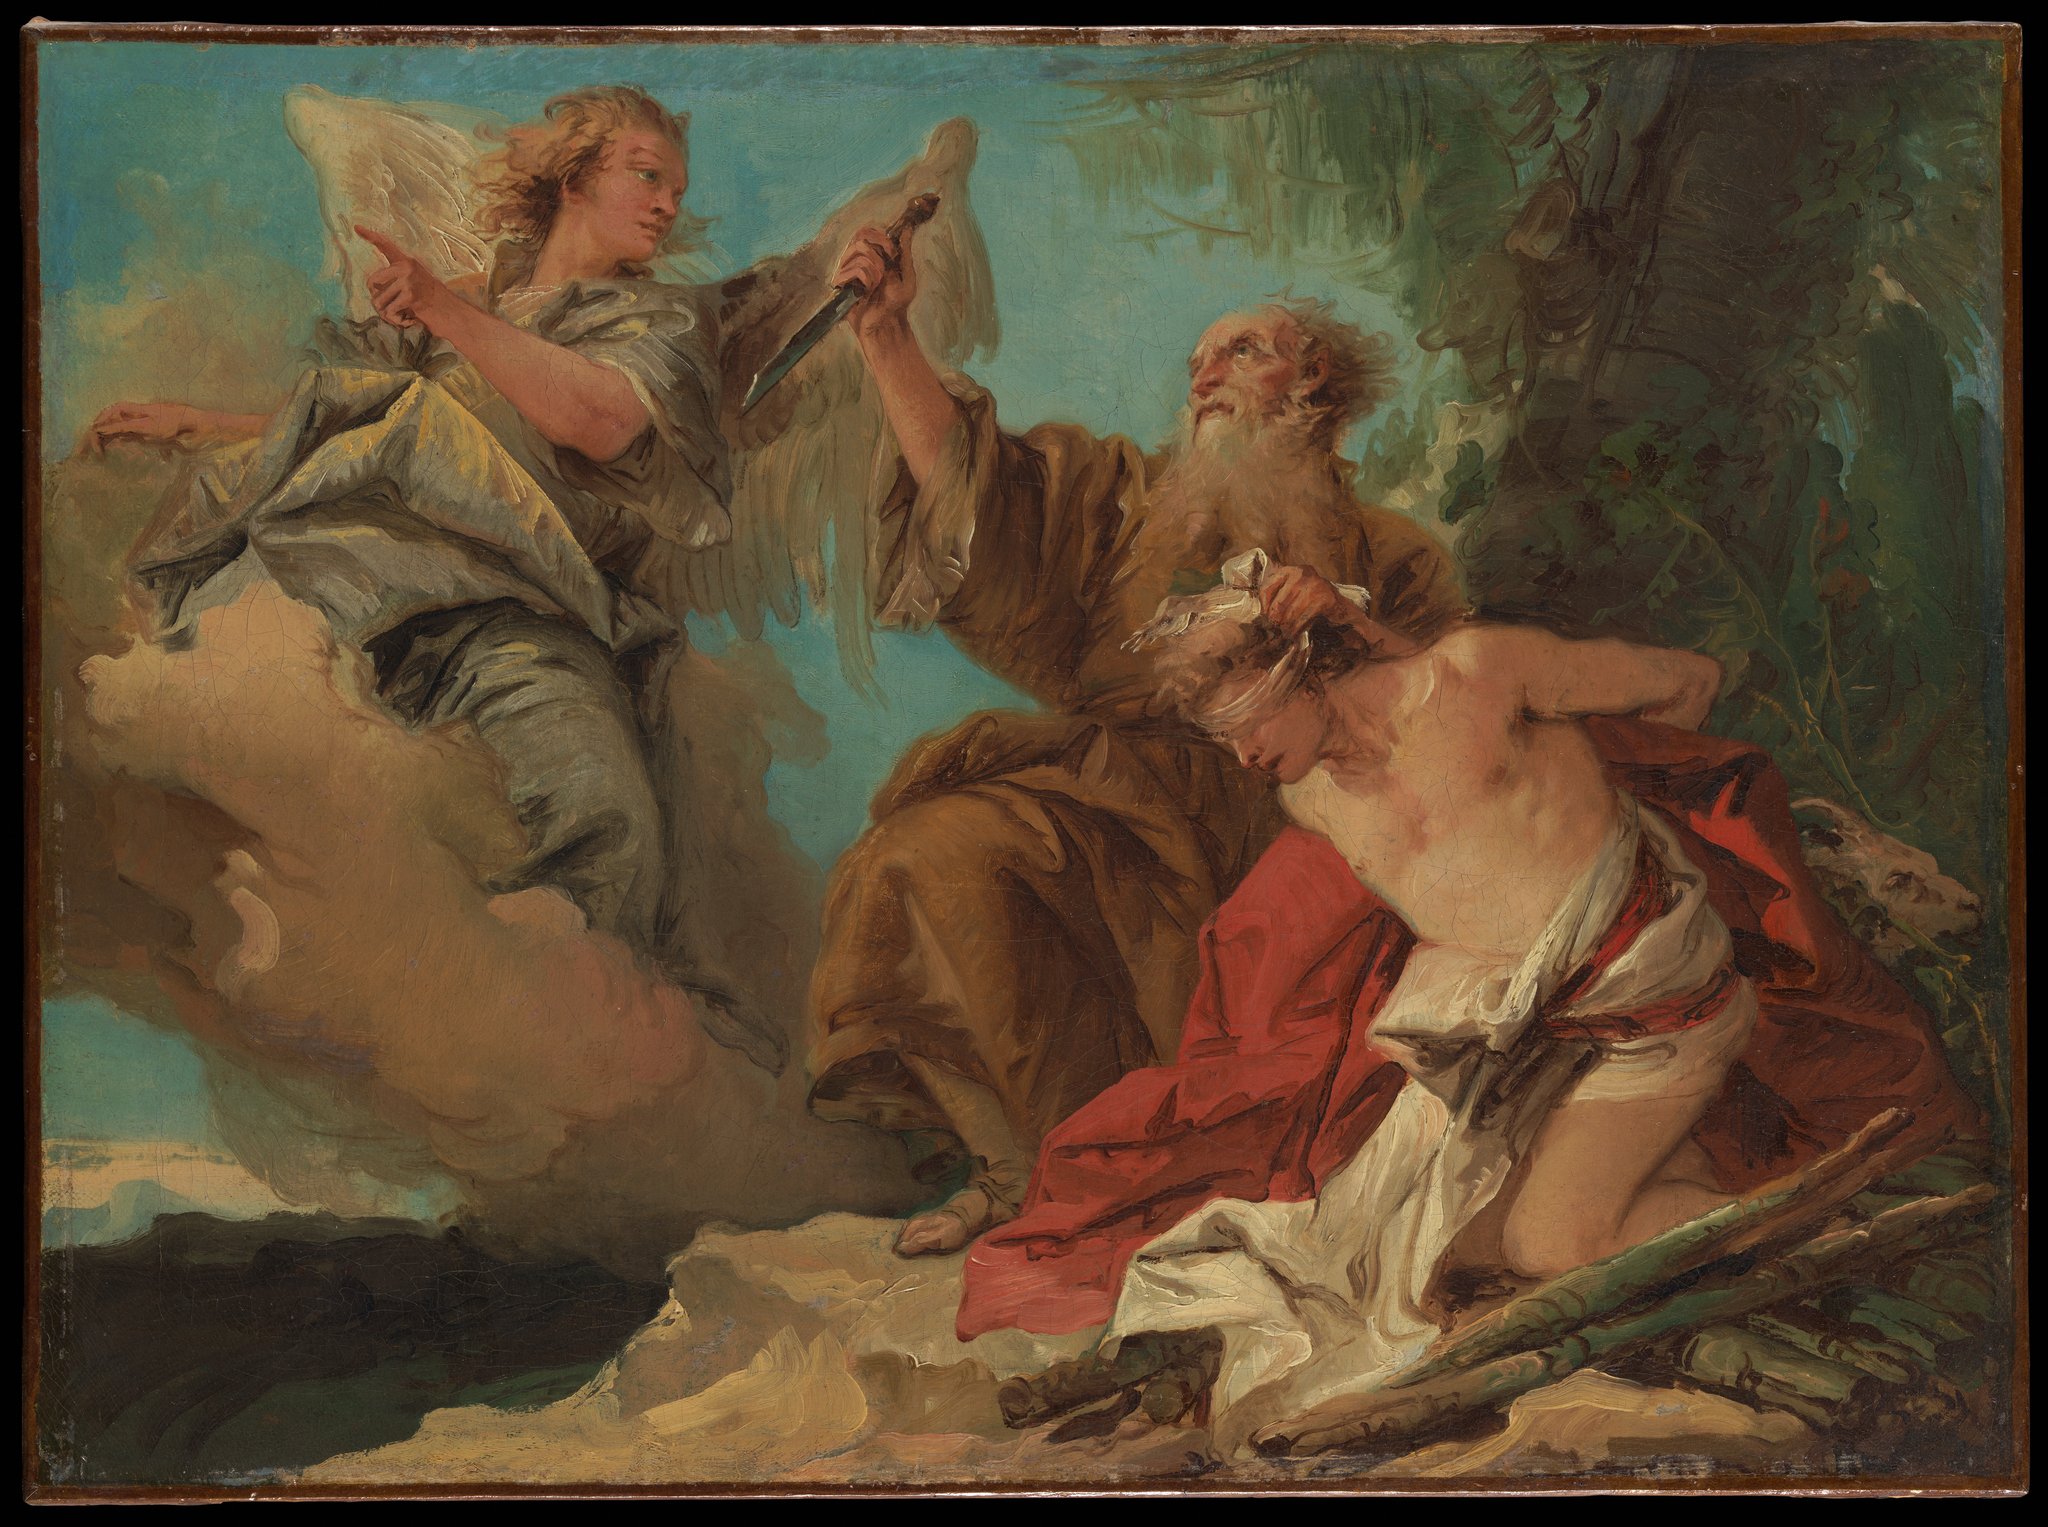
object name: painting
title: The Sacrifice of Isaac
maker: giovanni domenico tiepolo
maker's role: artist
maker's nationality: italian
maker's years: 1727-1804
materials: canvas, oil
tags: knives,angels,abraham